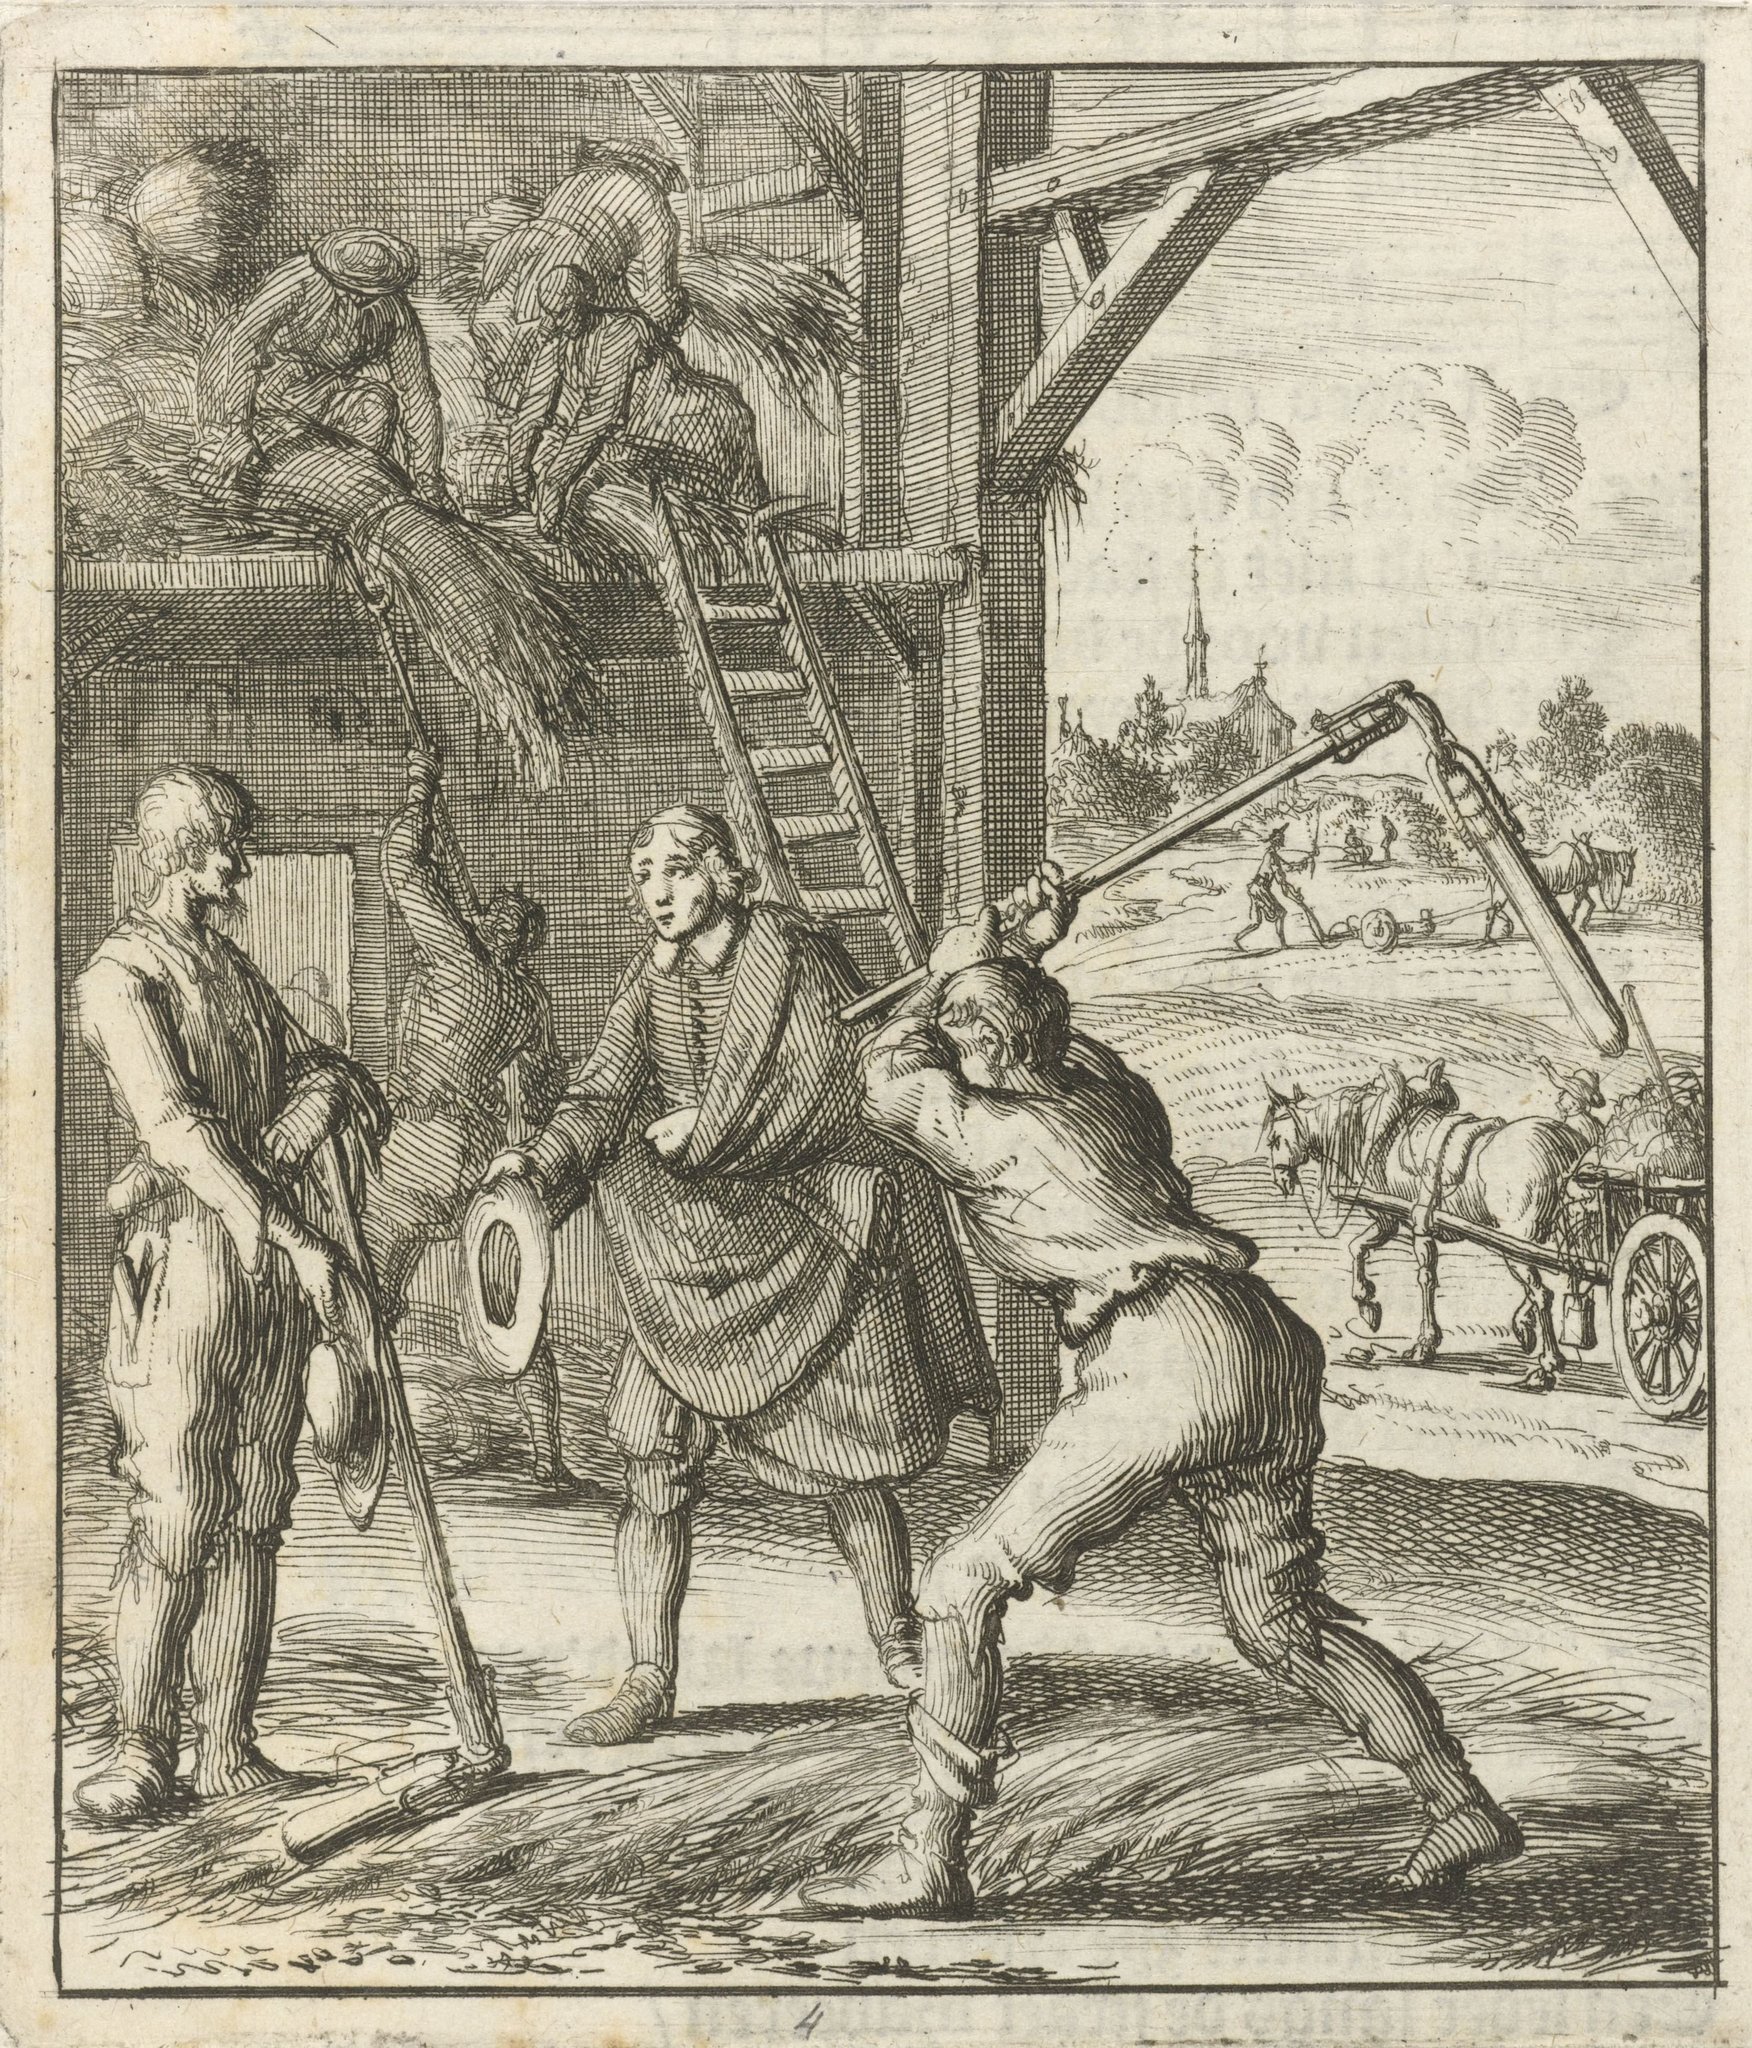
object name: book illustration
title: Schrijver Willem Sluiter bezoekt in een schuur twee dorsende boeren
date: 1687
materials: paper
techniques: etching, letterpress printing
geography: amsterdam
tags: barn - aa - civic architecture: inside, threshing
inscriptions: number: ‘4’, collector's mark: Lugt 2228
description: Illustratie uit: Sluiter, Willem. Buiten- eensaem huis- somer- en winter-leven. Amsterdam: Gerbrandt Schagen, 1687, p. 42.